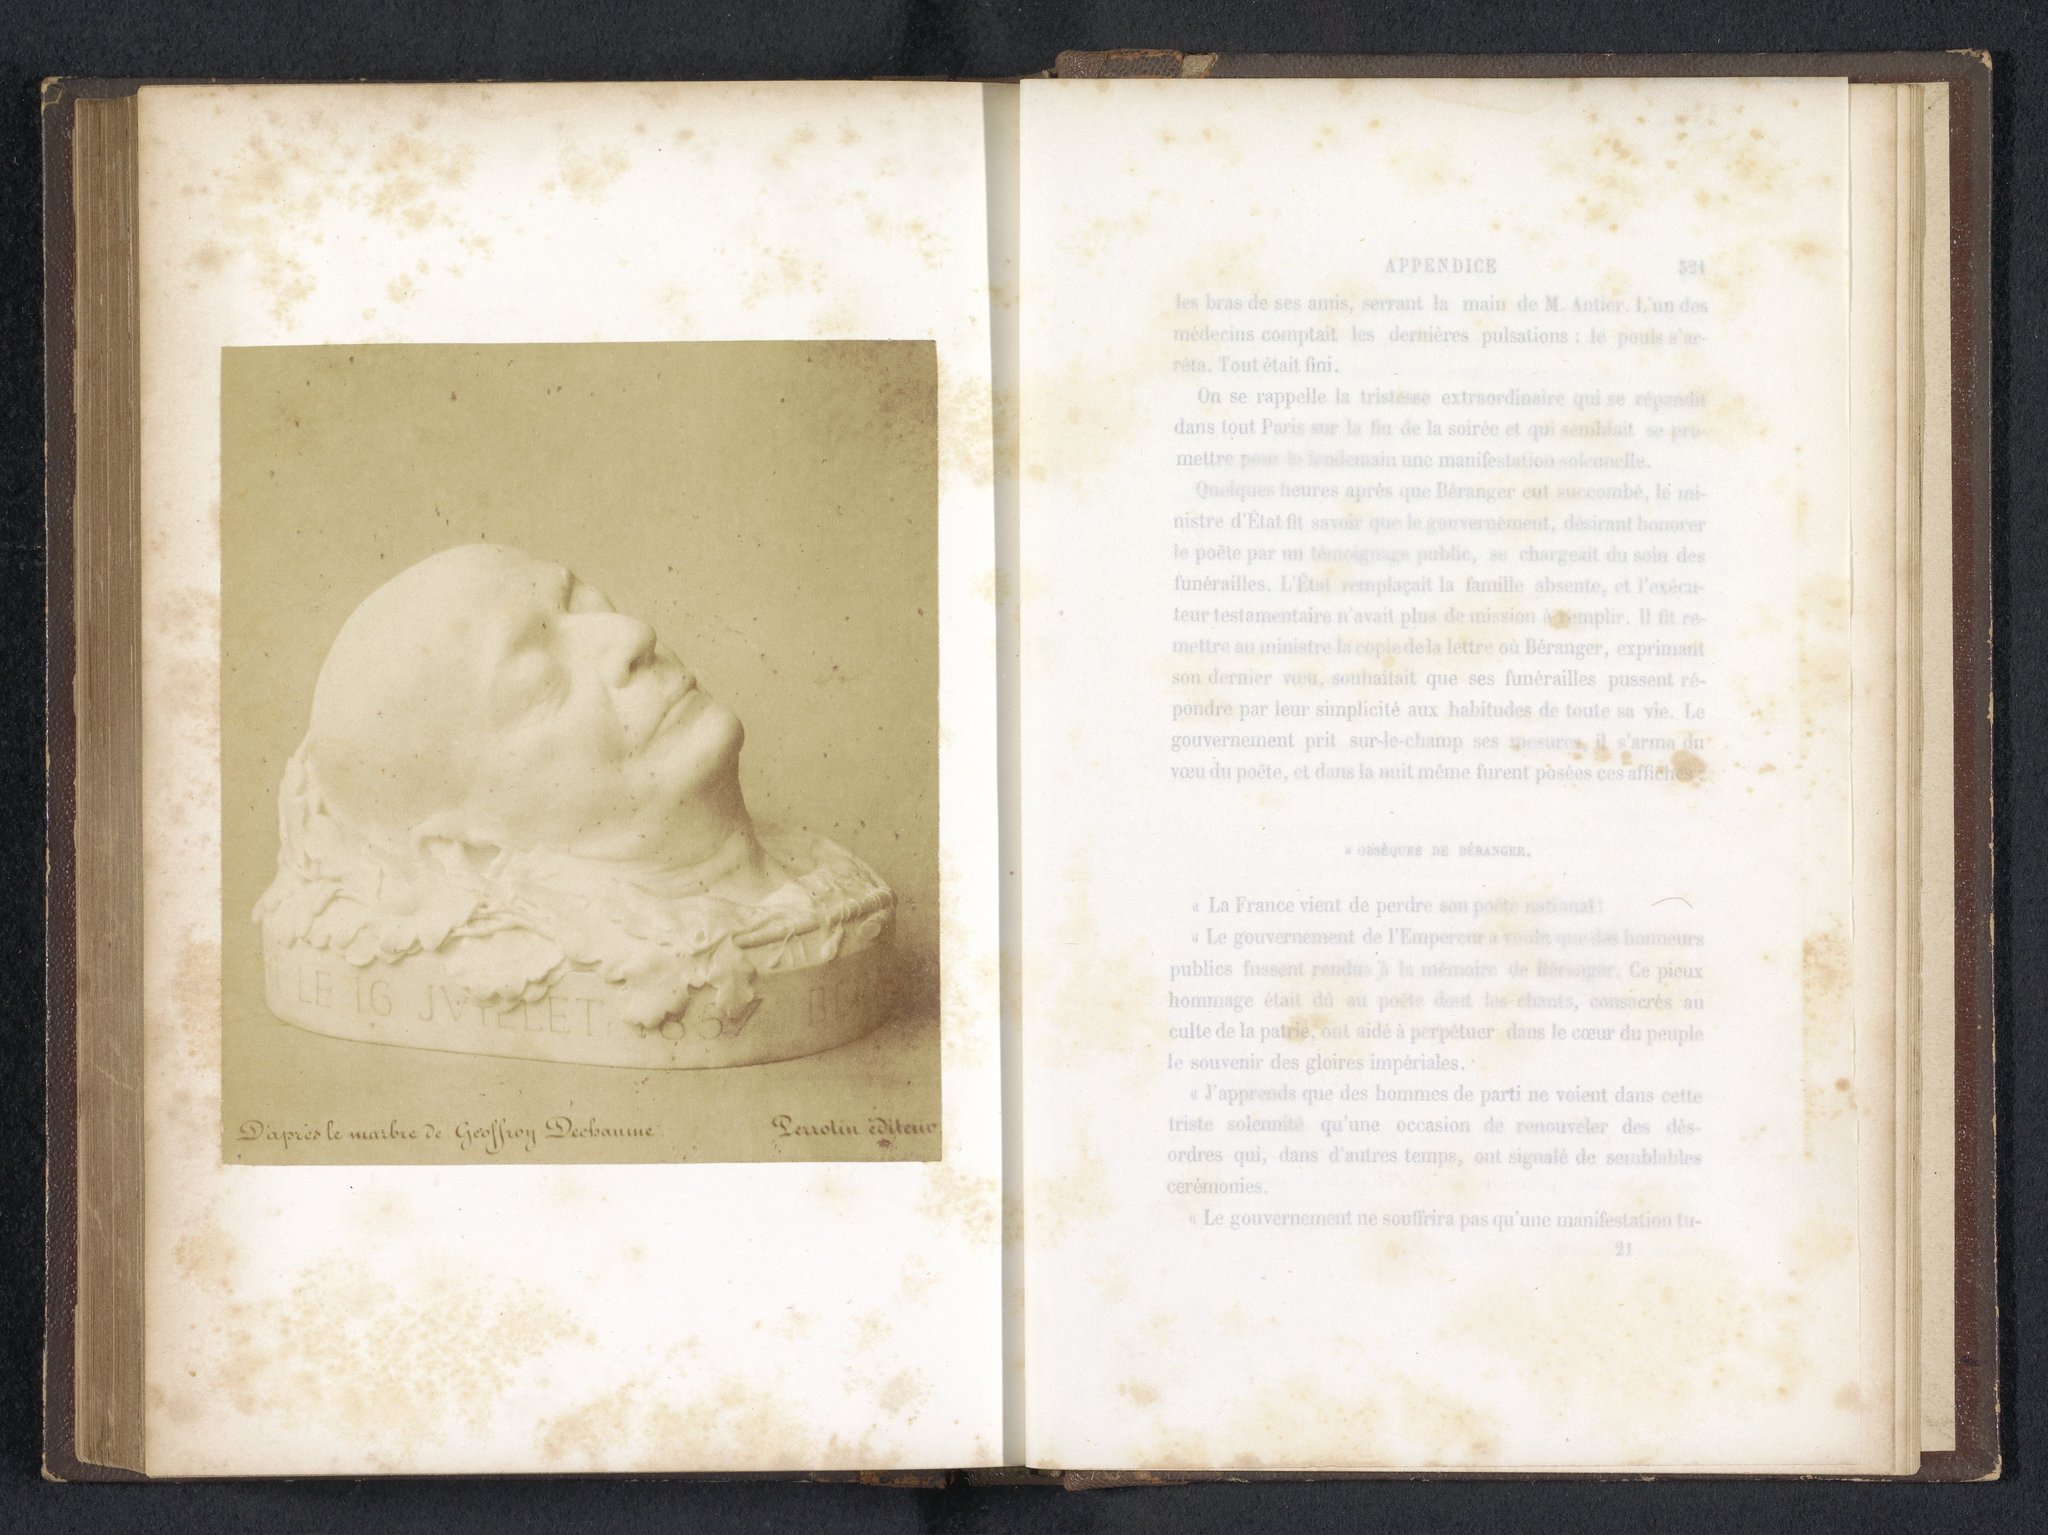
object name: page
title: D'apres le marbre de Geoffroy Dechaume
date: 1850-1857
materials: paper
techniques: albumen print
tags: paris, pierre-jean de béranger, death-mask